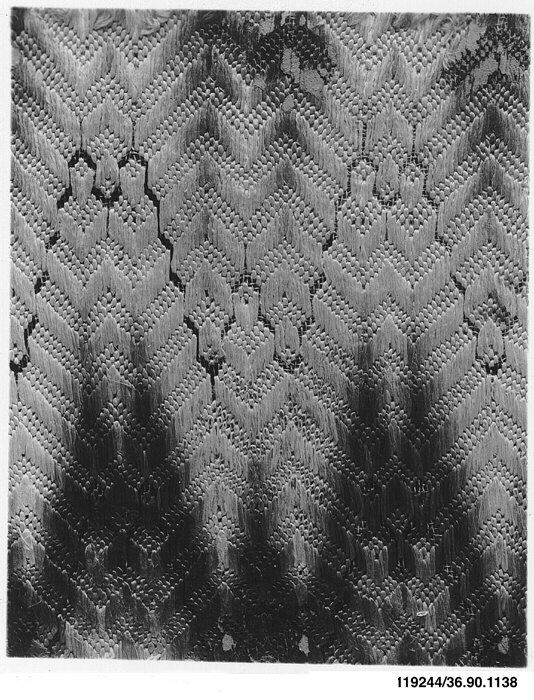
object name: piece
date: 1701-1800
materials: cotton, silk